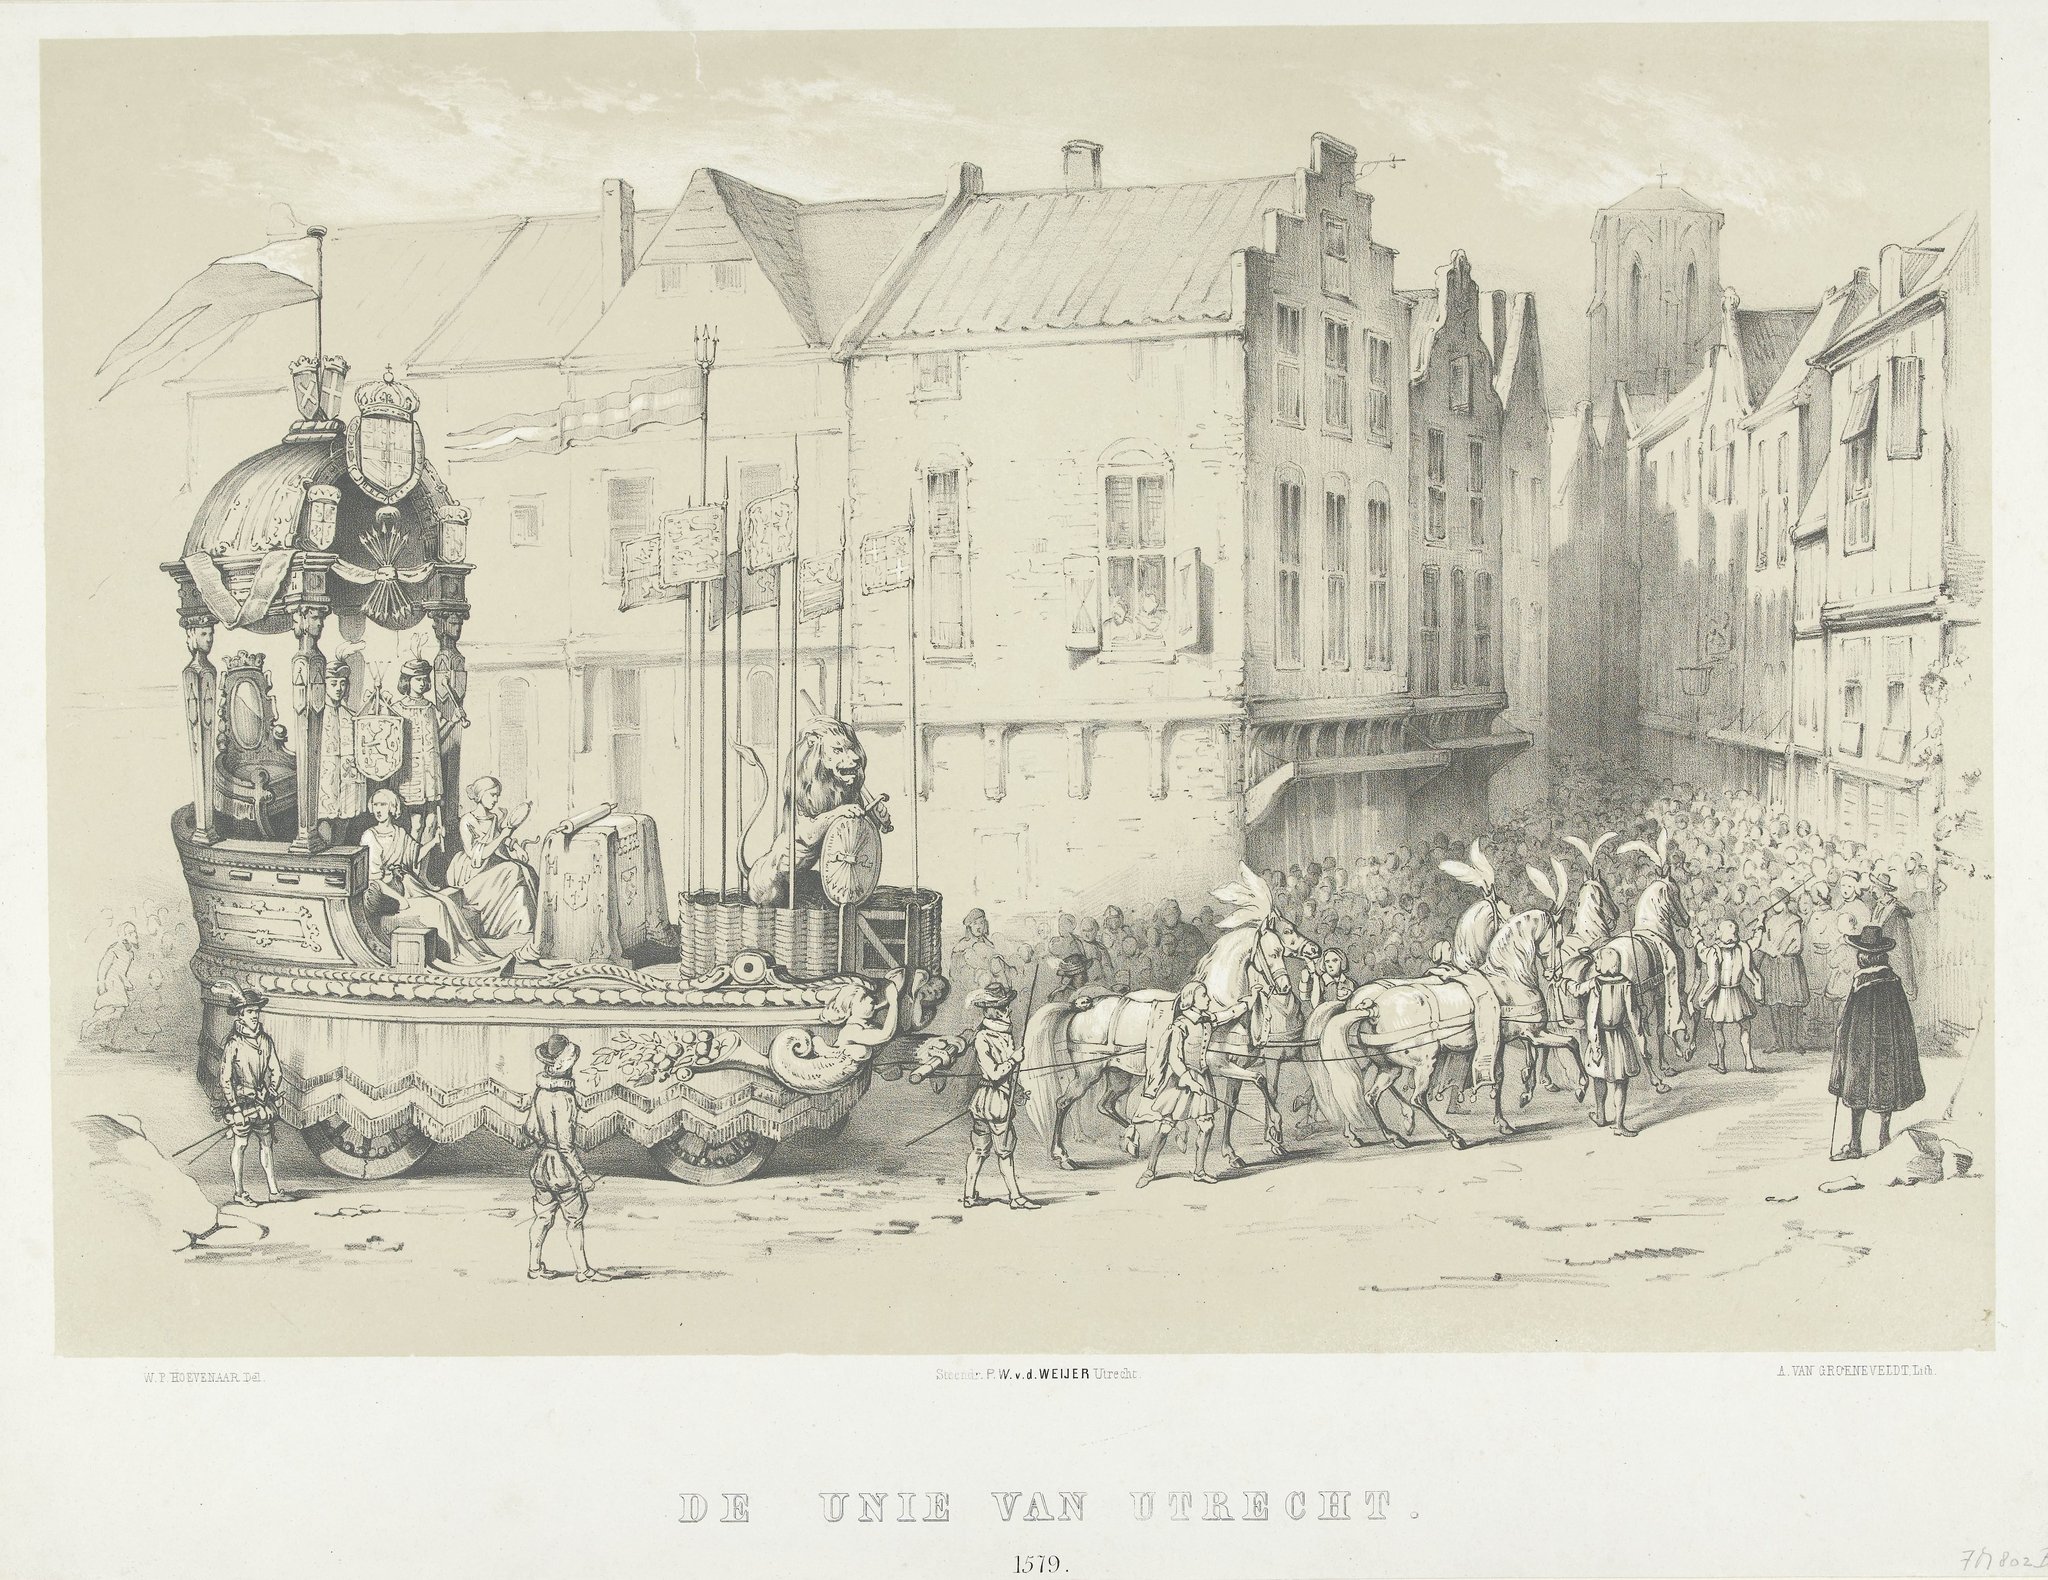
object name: print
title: De Unie van Utrecht. 1579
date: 1826-1863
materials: paper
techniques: tone lithography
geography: utrecht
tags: festivities (+ decorated float, wagon ~ festive activities), festivities on events of national importance, utrecht, union of utrecht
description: Praalwagen in de optocht bij de maskerade van Utrechtse studenten in 1853, allegorisch verbeeldende de Unie van Utrecht gesloten in januari 1579. De wagen wordt door een span van zes paarden door de straten van een stad Utrecht getrokken. Op de wagen de Hollandse Leeuw in de Hollandse Tuin met vaandels van de zeven provincies verbonden in de Unie, met personificaties van Waakzaamheid en Voorzichtigheid. Achterop een lege troon.